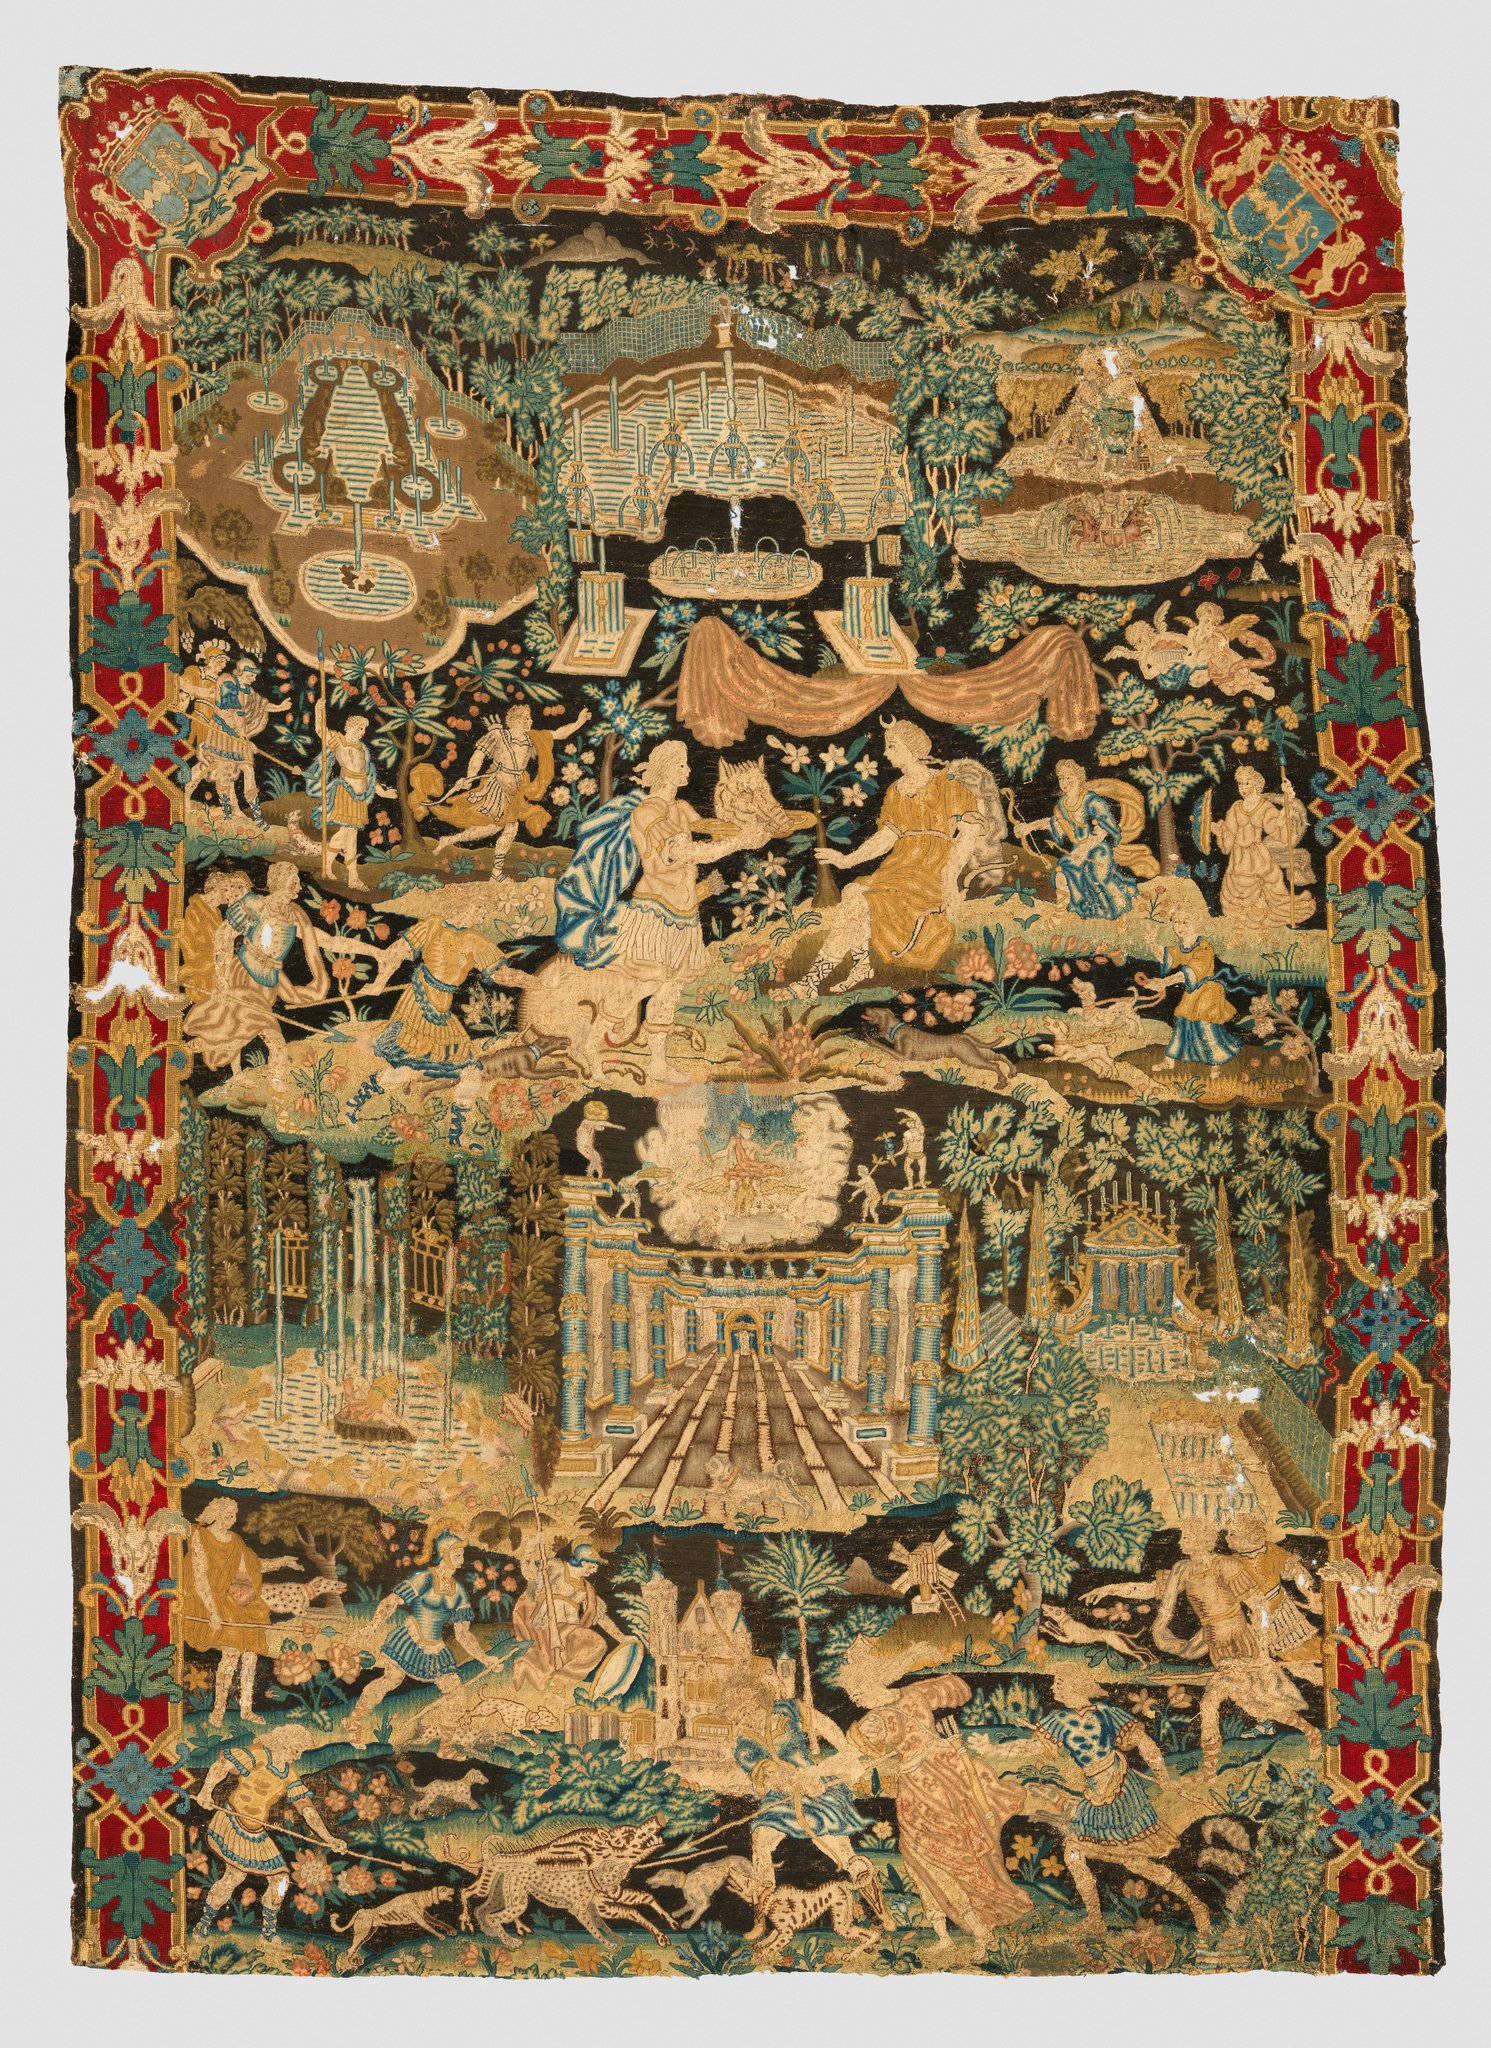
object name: panel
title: Atalanta and Meleager with Fountains of Versailles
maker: antonio tempesta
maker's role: artist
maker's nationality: italian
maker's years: 1555-1630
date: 1667-1700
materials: canvas, silk, wool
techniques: stitching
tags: gardens,men,women,hunting,boars,dogs